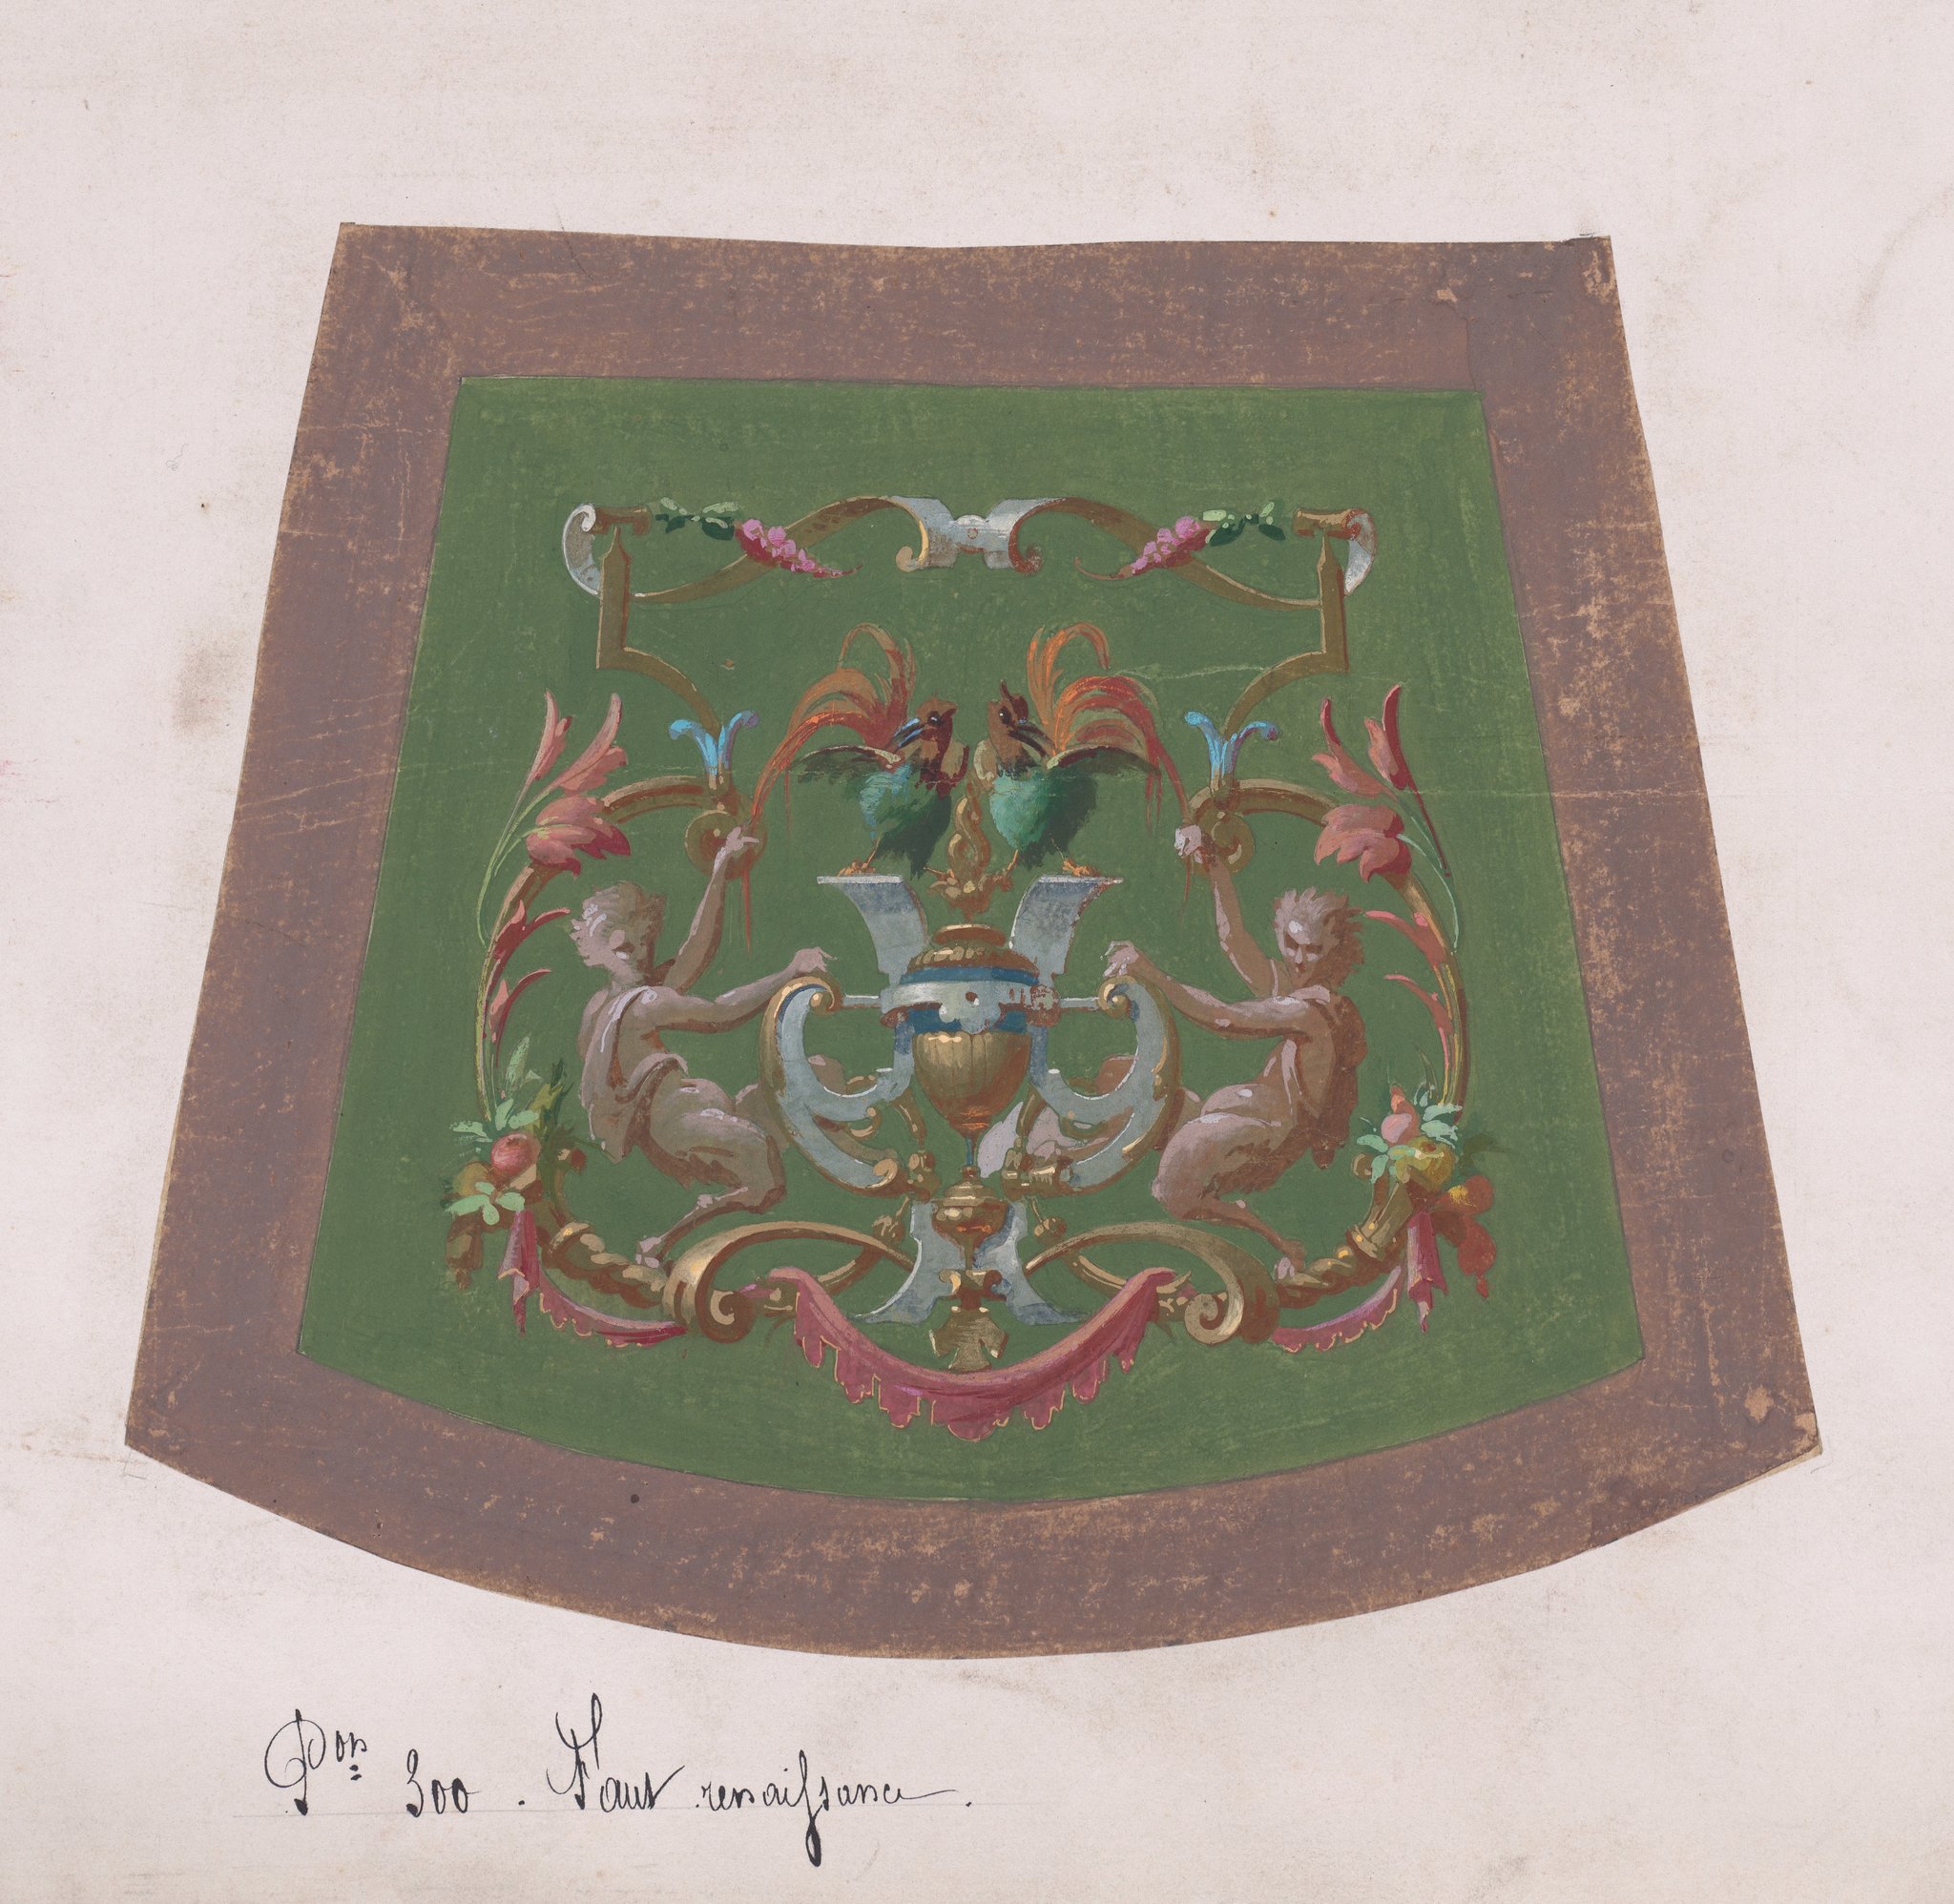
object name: drawing ornament architecture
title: Design for a Chair Seat Cover with a Classical-Inspired Vase with Two Handles, Two Exotic Birds and Two Half-Human Grotesque Figures Inside an Ornamental Frame with Two Cornucopias Holding Bundles of Leaves and Fruits and Decorated Scrolls of Leaves and Flowers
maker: anonymous, french, 19th century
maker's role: designer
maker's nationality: french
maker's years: 1800-1900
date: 1870-1900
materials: gouache, watercolor